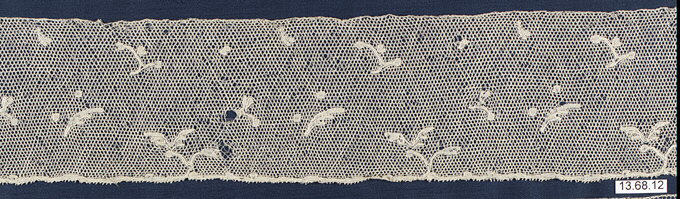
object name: fragment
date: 1801-1833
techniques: lace